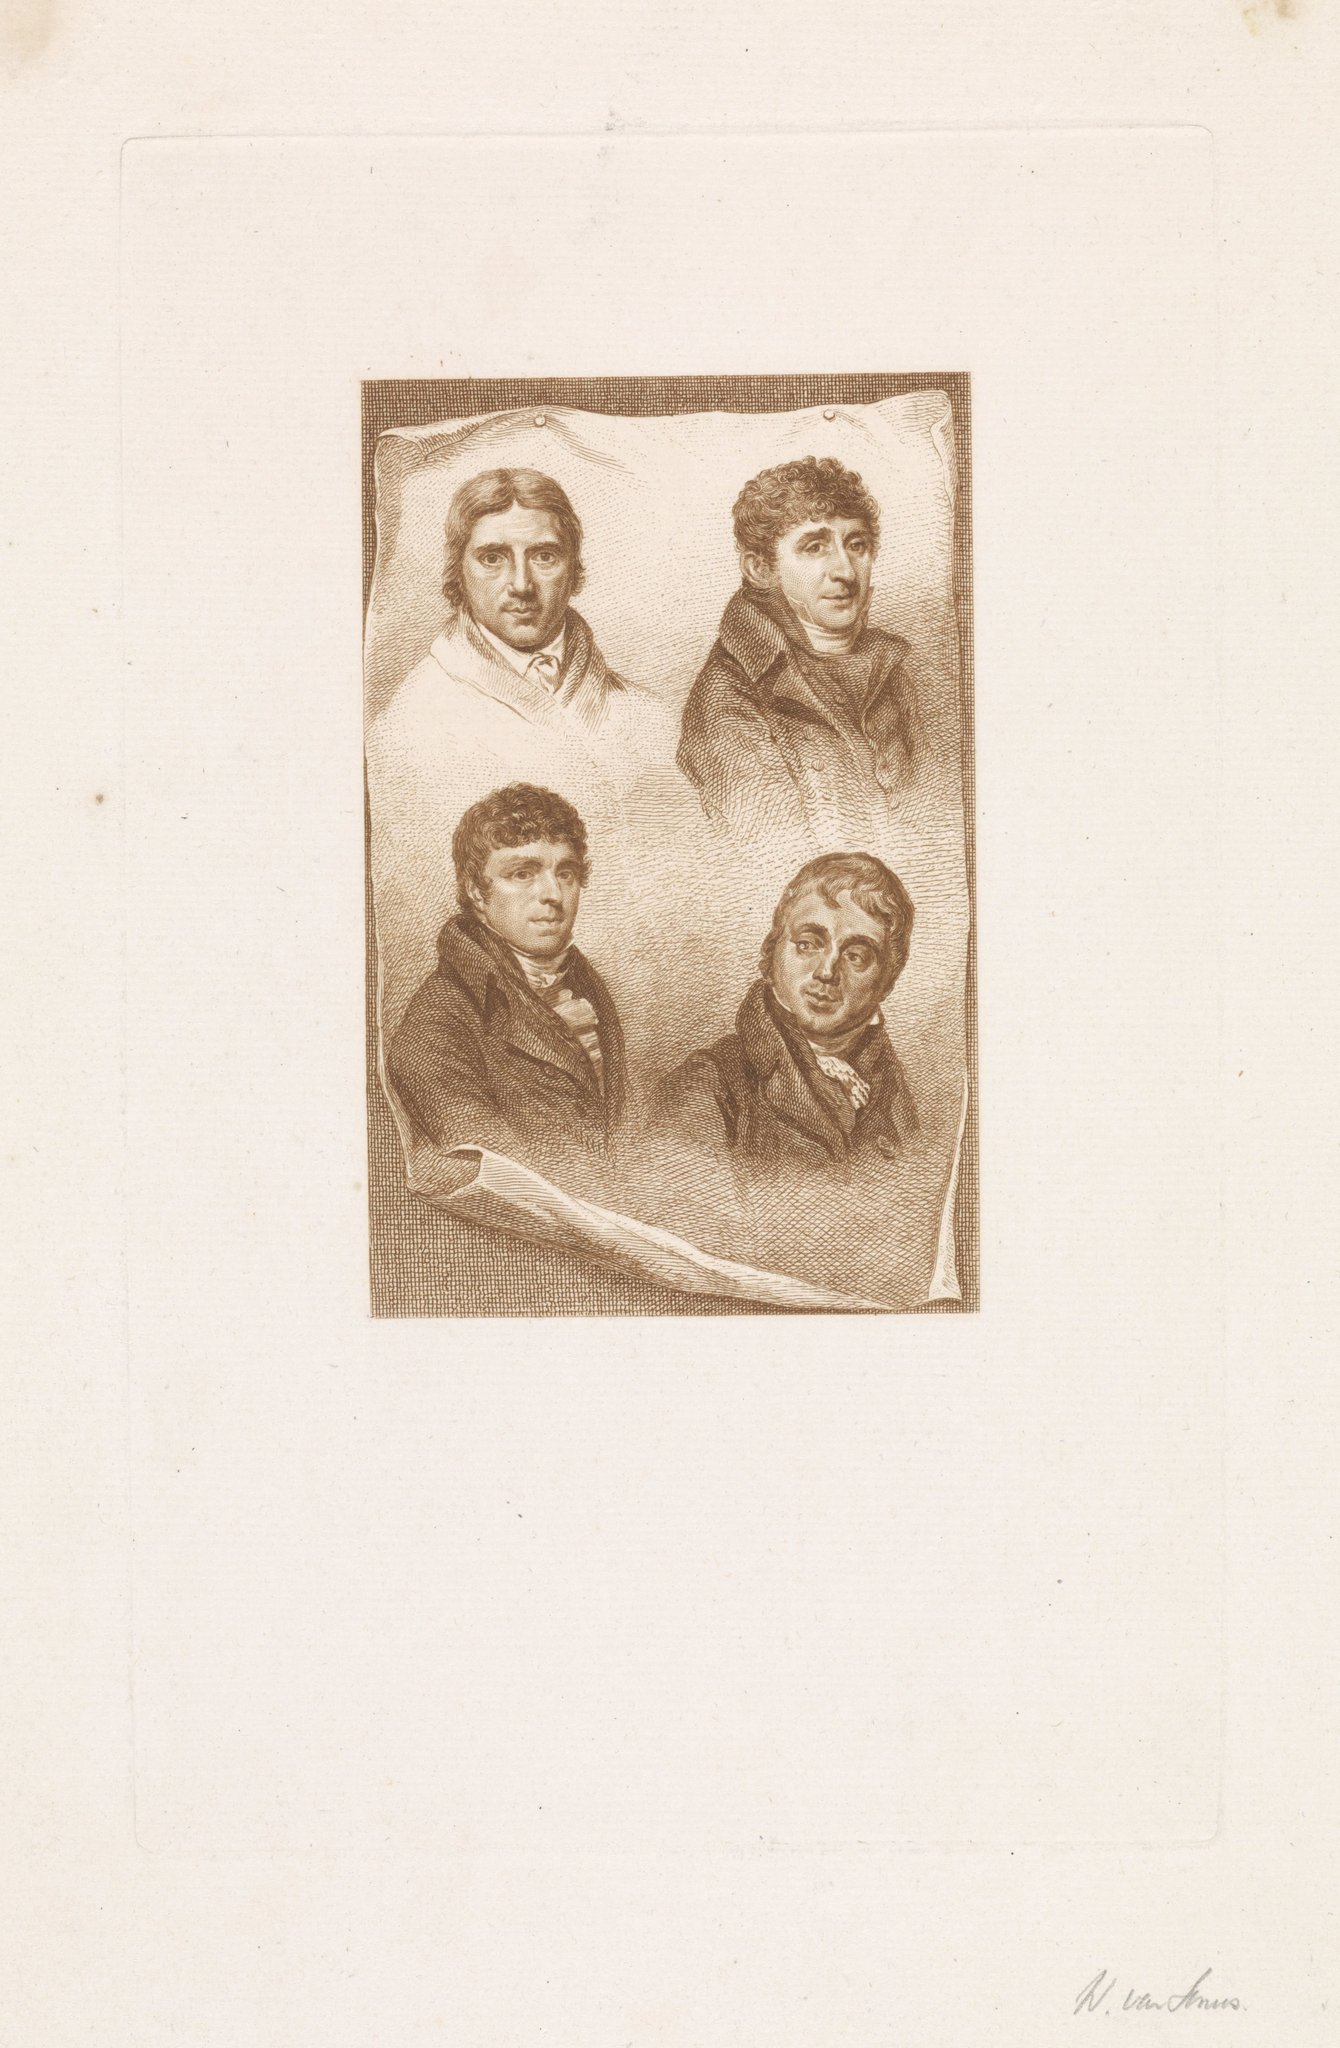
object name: print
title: Portretten van Taco Scheltema, Nicolaas Baur, Willem Bartel van der Kooi en Martinus Schouman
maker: willem van senus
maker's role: painter, print maker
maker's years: 1773-1851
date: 1783-1851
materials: paper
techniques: engraving, etching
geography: netherlands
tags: dordrecht, aert schouman, harlingen, draughtsman, nicolaas baur, painter, print maker, willem bartel van der kooi, taco scheltema (i)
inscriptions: collector's mark: Lugt 2228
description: Portretten van de Nederlandse kunstenaars Taco Scheltema, Nicolaas Baur, Willem Bartel van der Kooi en Martinus Schouman op een blad dat onderaan omkrult en bovenaan aan twee punten is bevestigd tegen een wand.